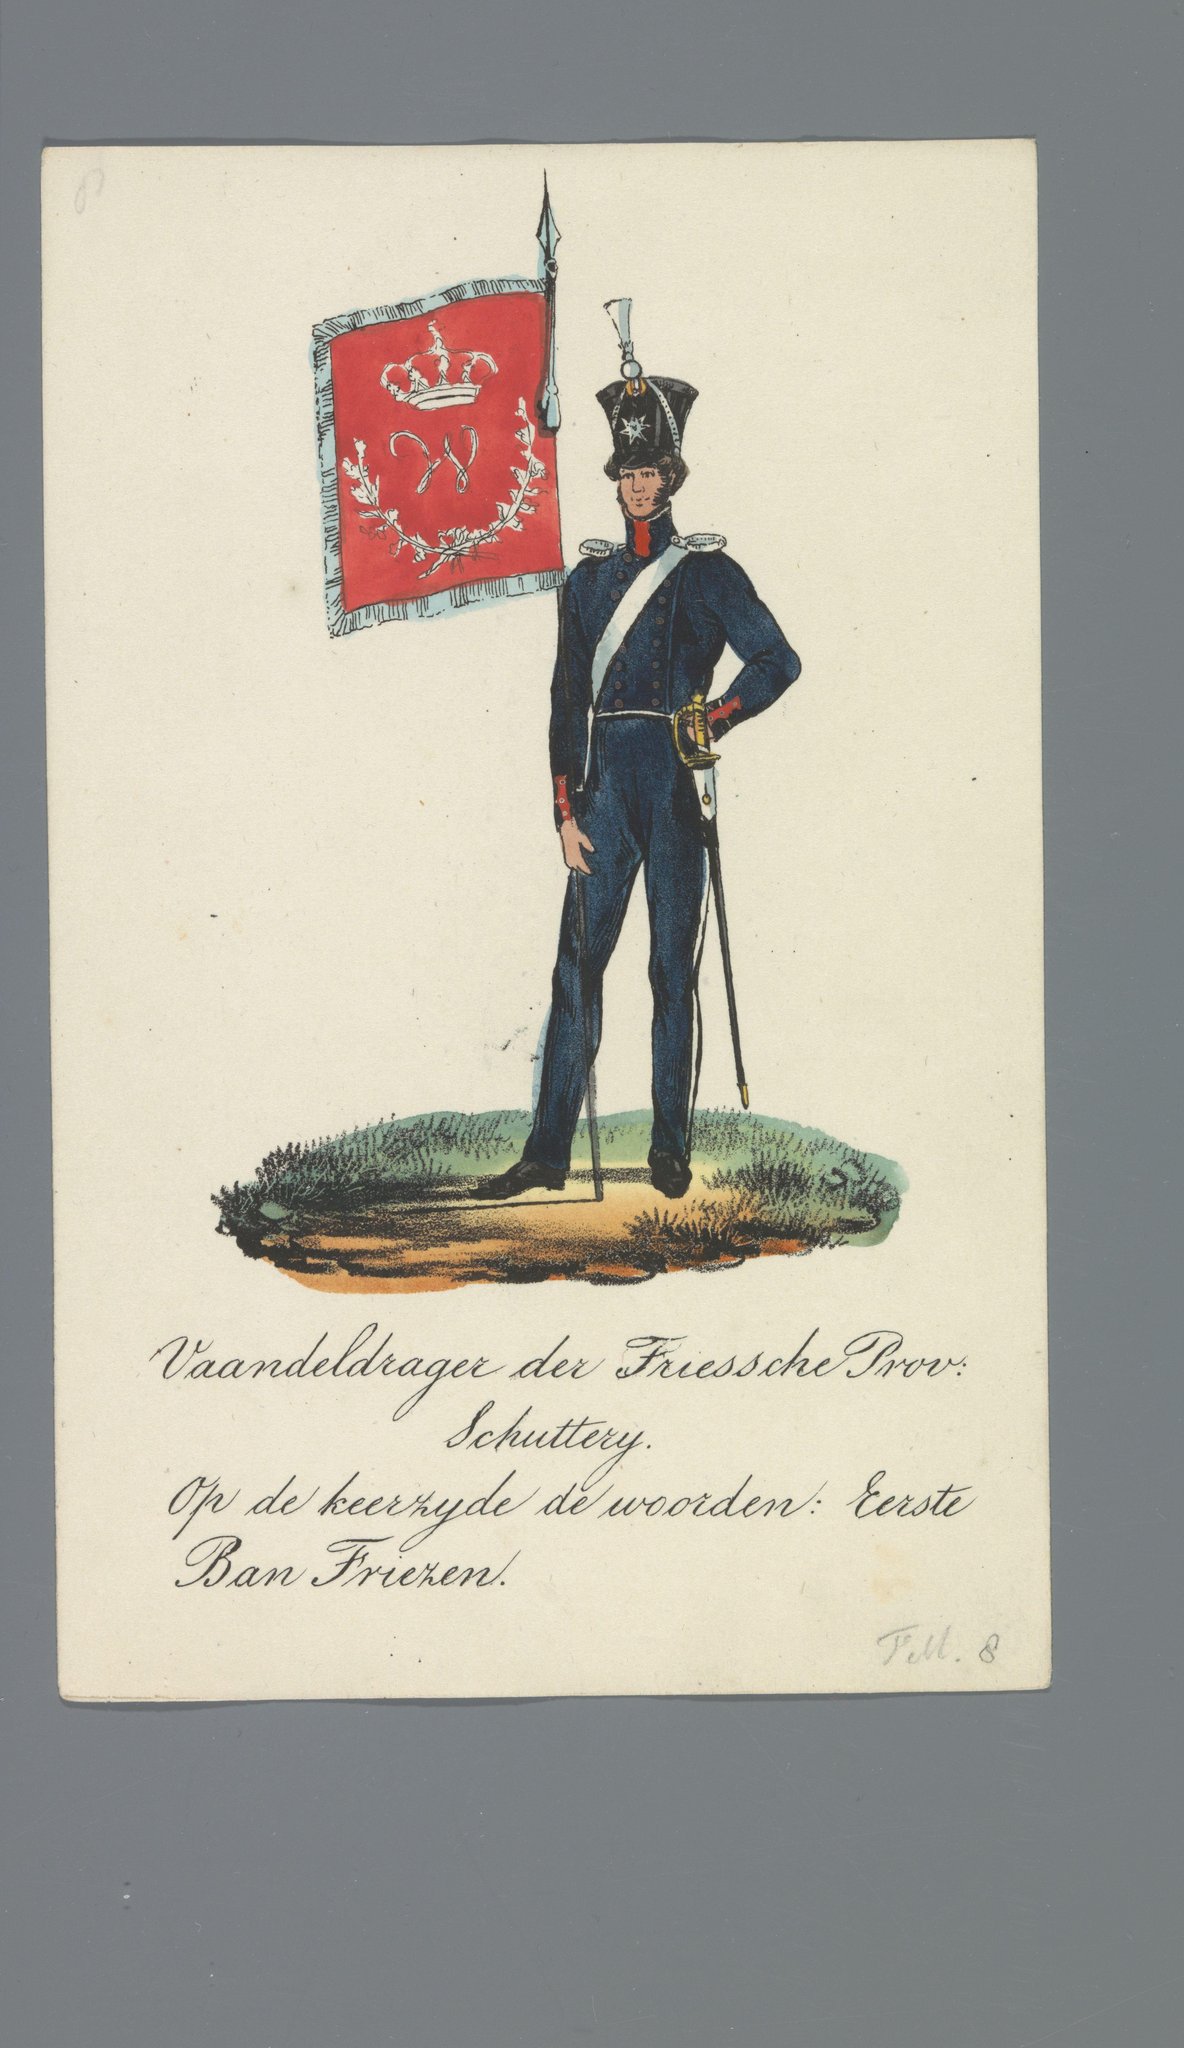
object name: print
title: Vaandeldrager der Friessche Prov: Schutterij. Op de keerzijde de woorden: Eerste Ban Friezen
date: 1835-1850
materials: paper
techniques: hand coloring, lithograph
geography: netherlands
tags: standard-bearer, flag-bearer, (military) uniforms, clothes, costume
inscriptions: collector's mark: Lugt 2227, collector's mark: Lugt 2228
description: Staande schutter, vaandeldrager met het vaandel van het 1e Bataljon 1e Afdeling Friese Schutterij. Onderdeel van een serie van 157 losse bladen met Nederlandse militaire uniformen in de jaren 1830-1832.